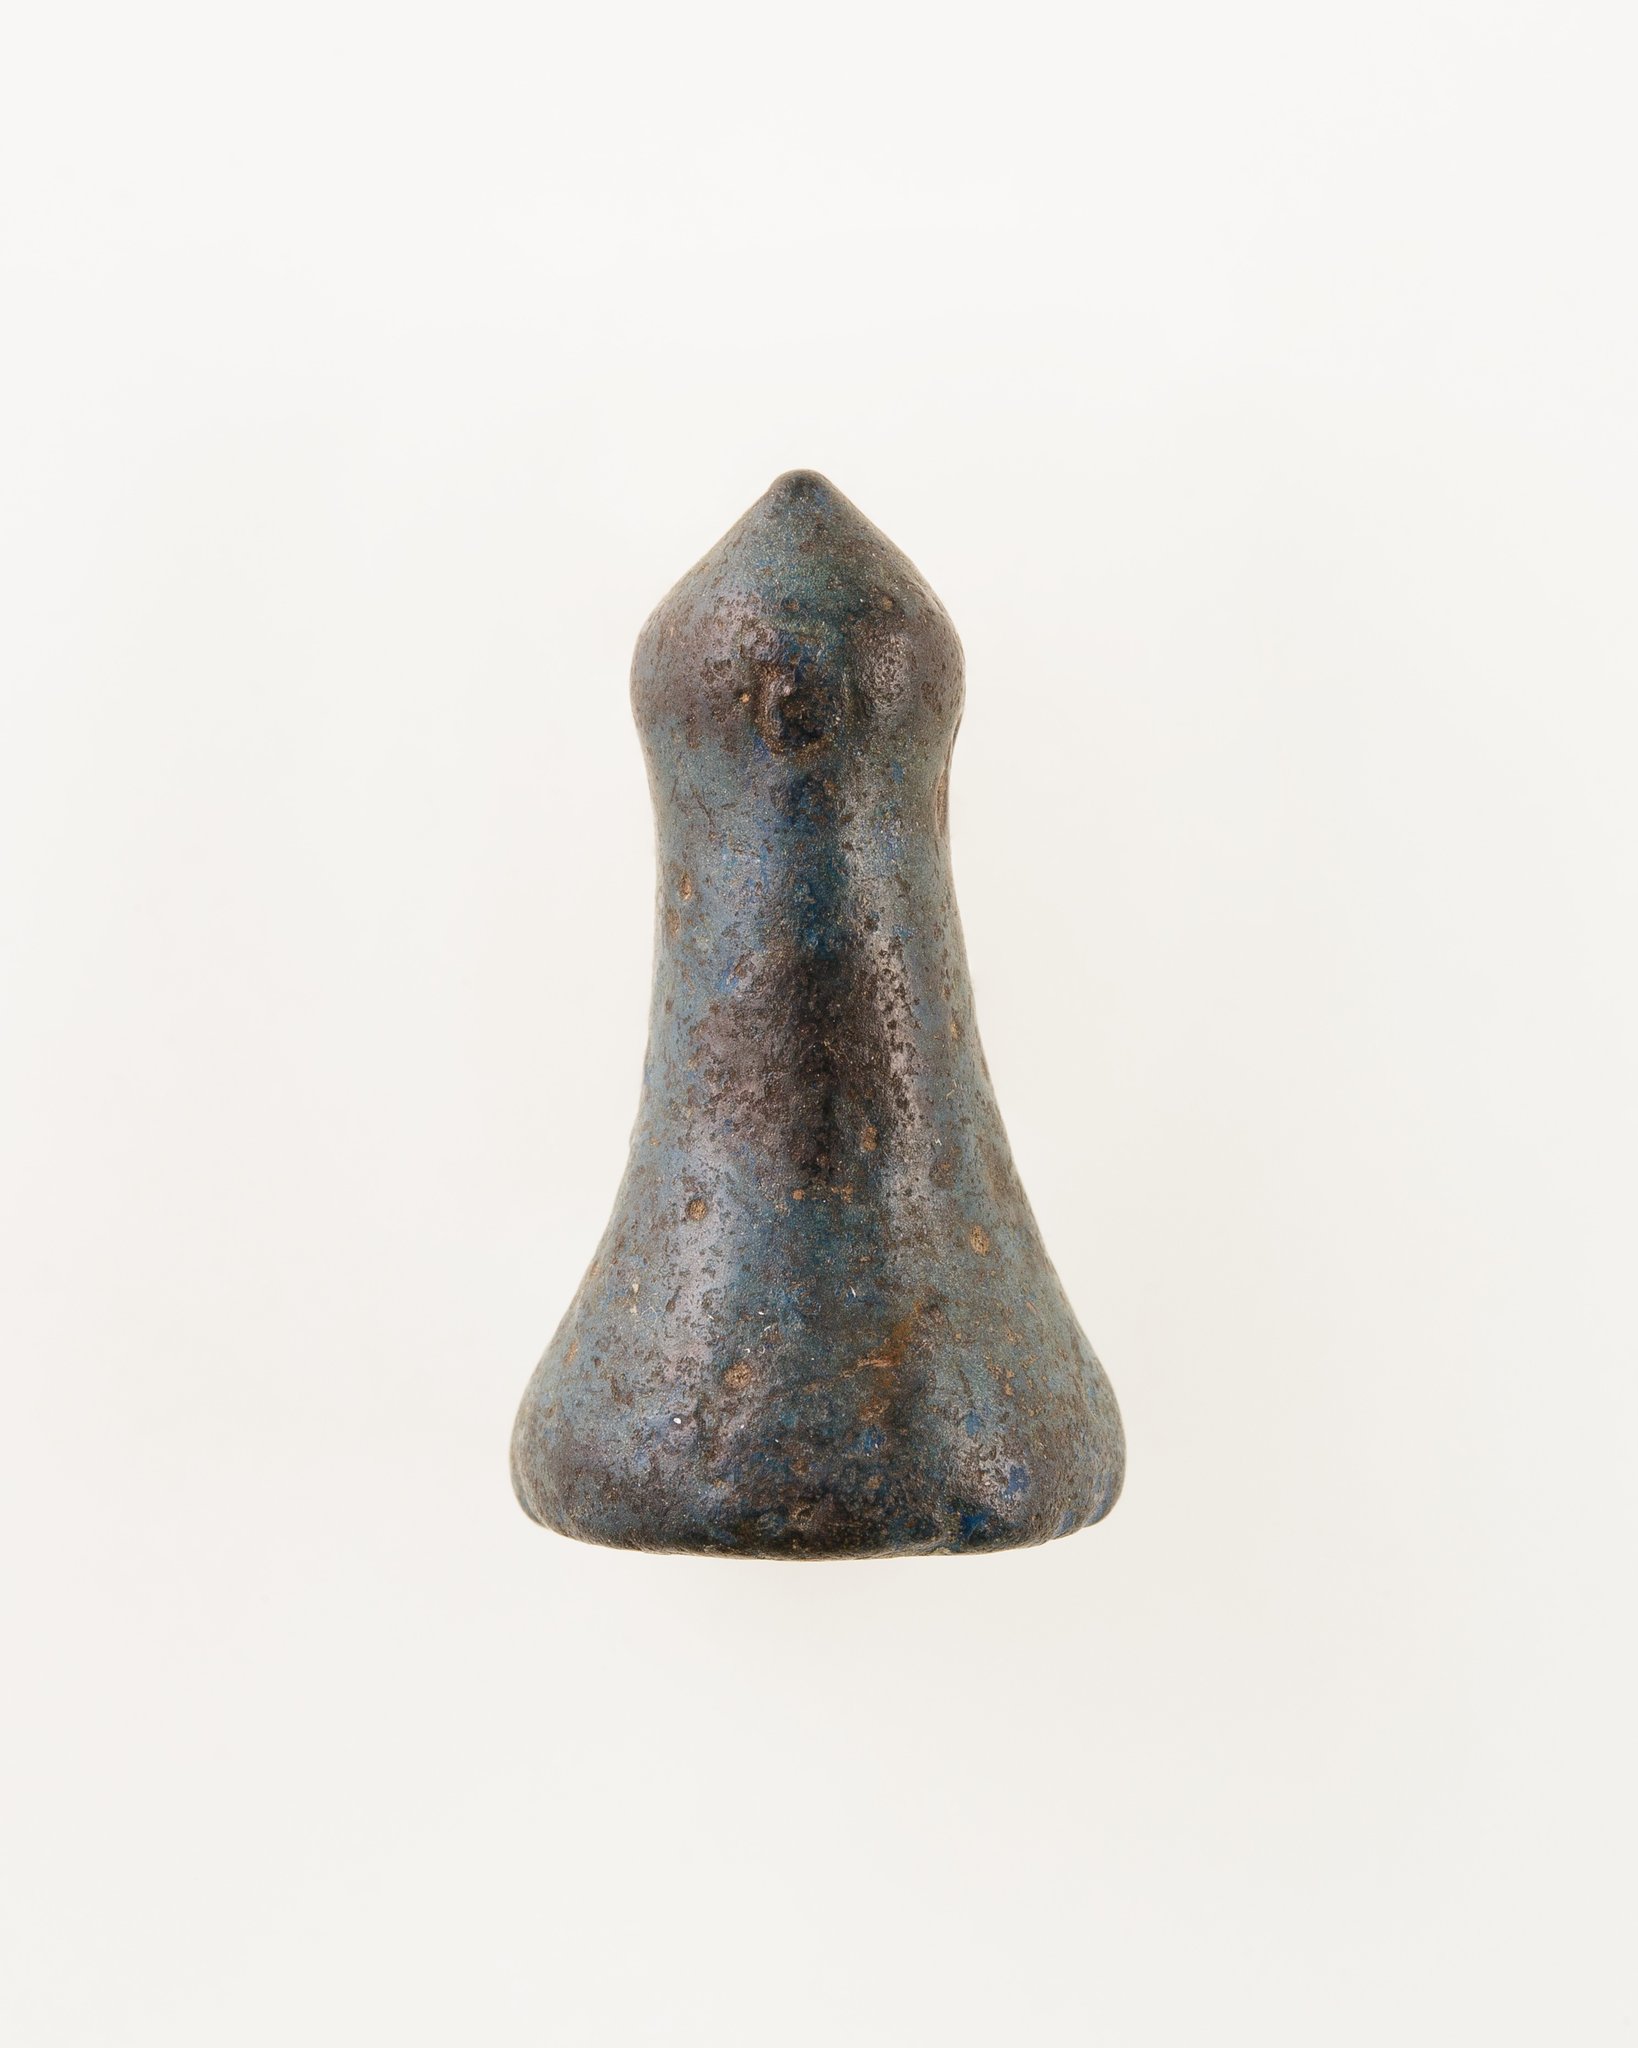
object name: cone shaped game piece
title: Cone-shaped Game Piece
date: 1070-525 BCE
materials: faience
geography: egypt